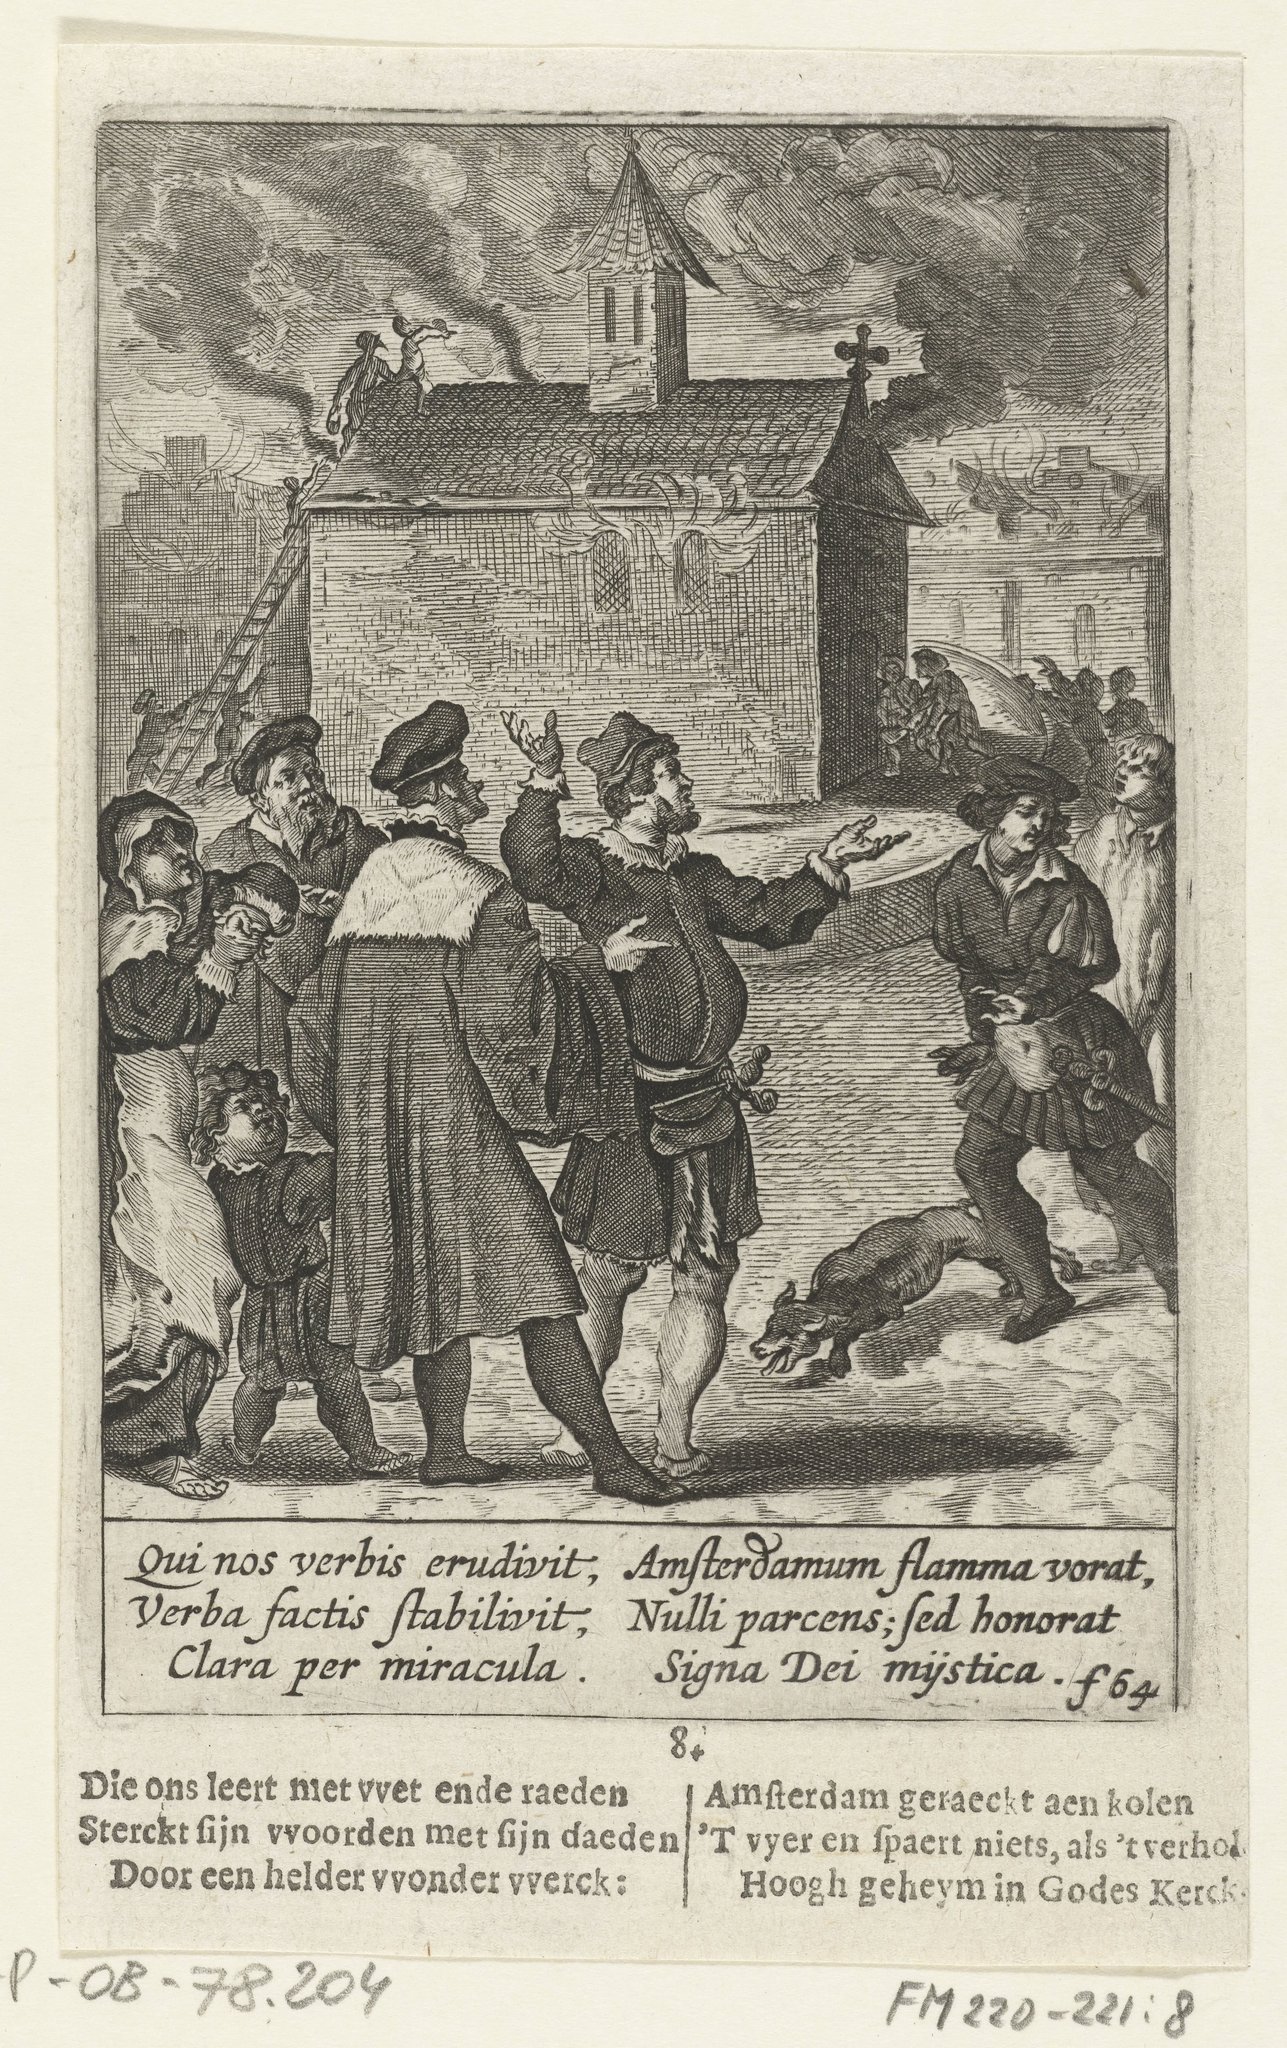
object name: history print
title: De kerk waar de hostie wordt bewaard brandt af maar de hostie blijft gespaard, 8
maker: Anonymous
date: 1639-1699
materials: paper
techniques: engraving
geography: low countries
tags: amsterdam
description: De kerk waar de hostie wordt bewaard brandt af maar de hostie blijft gespaard. Op de voorgrond jammerende toeschouwers. Prent nr. 8 uit de serie van 16 voorstellingen van Het Mirakel van Amsterdam, naar de gebeurtenissen op 15 maart 1345. Kopieën naar de reeks van Bolswert. Onder de voorstelling in de plaat gegraveerd een zesregelig vers in het Latijn, daaronder een zesregelig vers in boekdruk in het Nederlands.